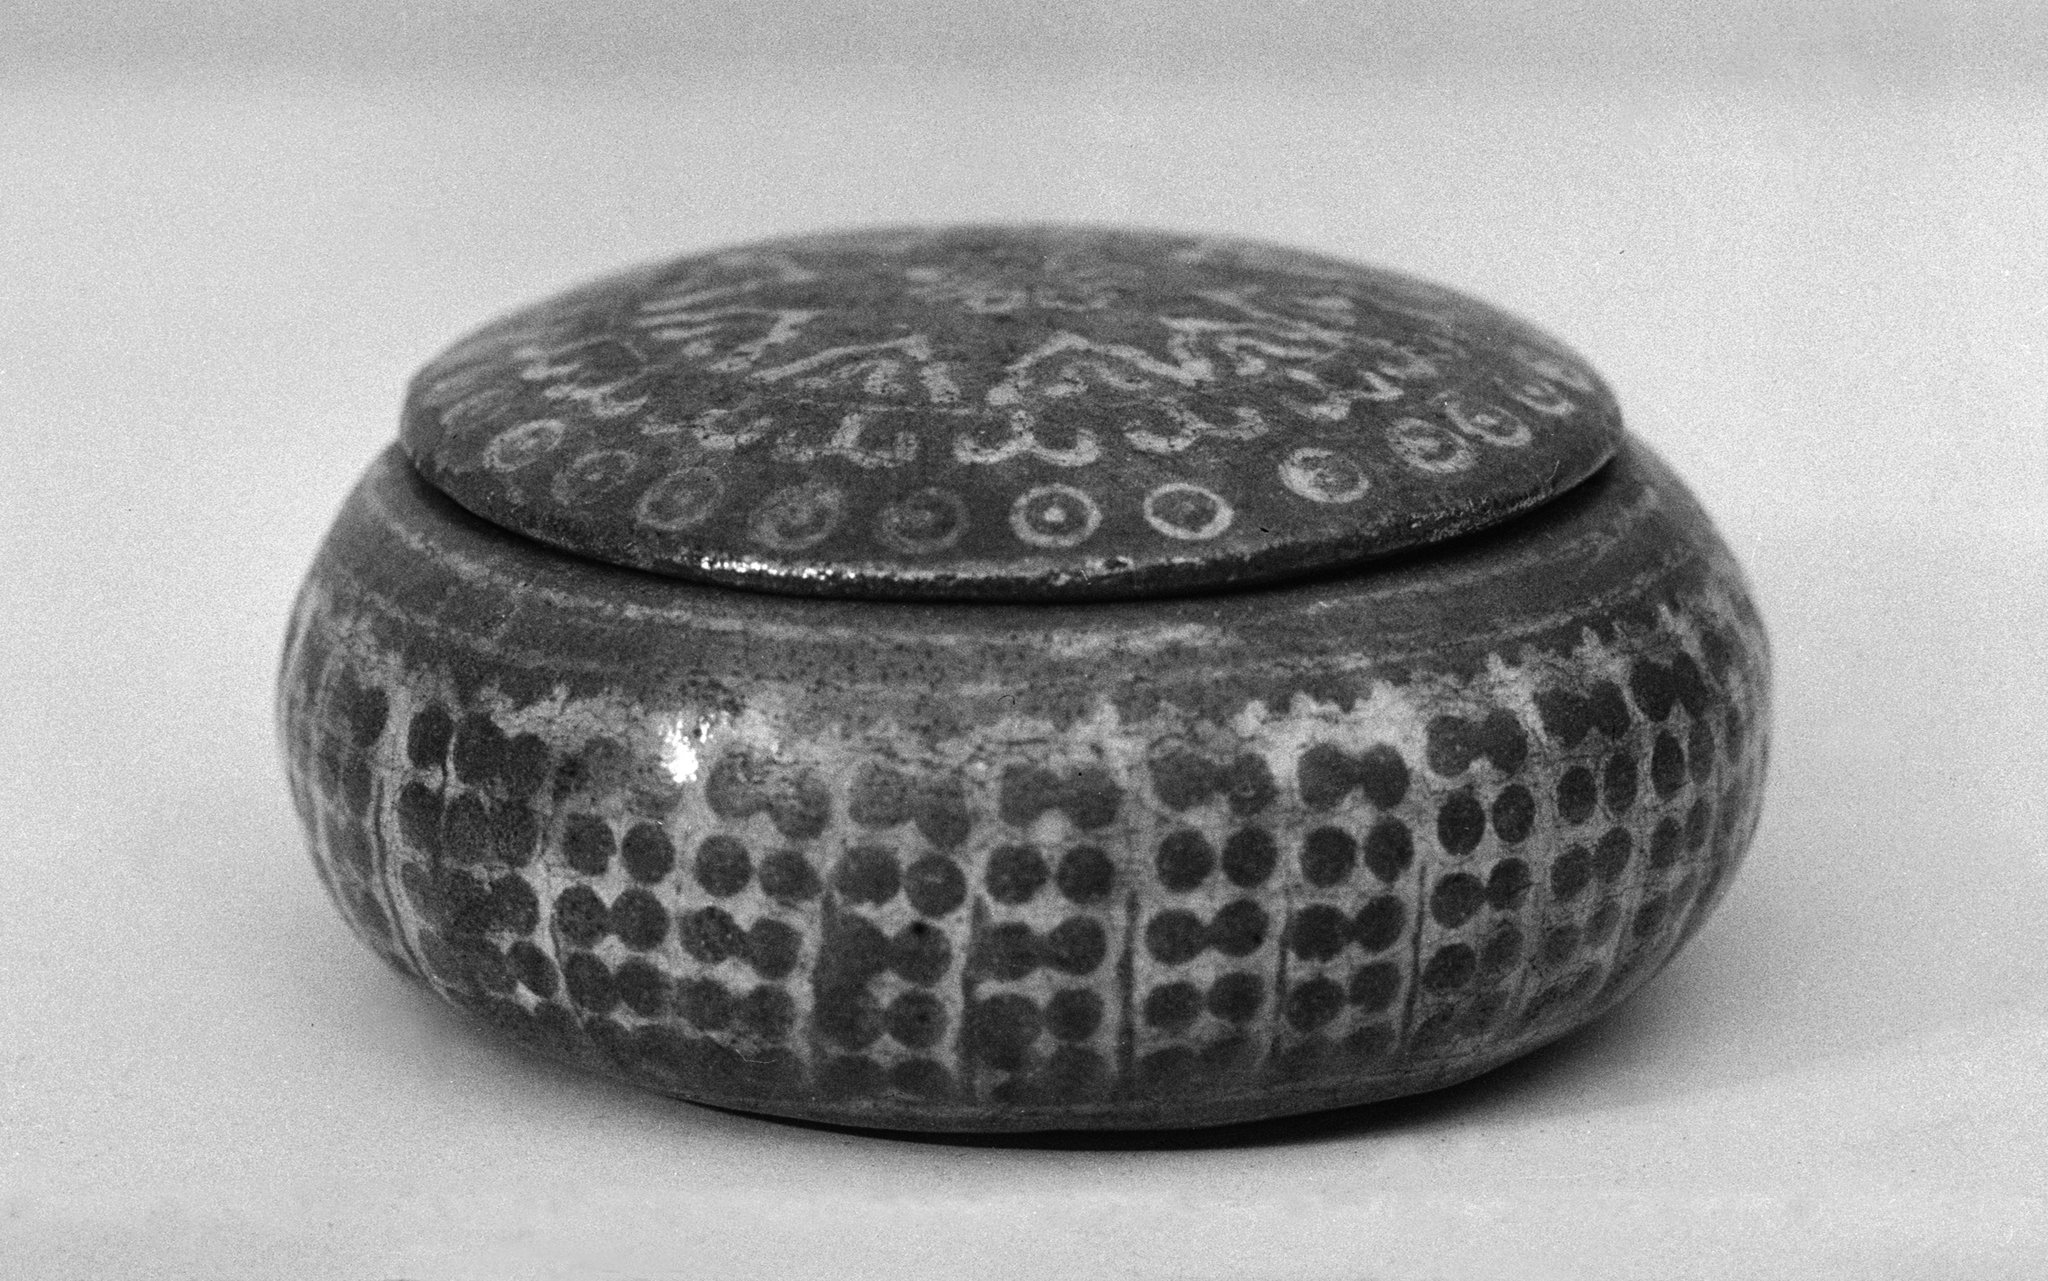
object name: covered incense box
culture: korean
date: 1201-1400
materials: clay